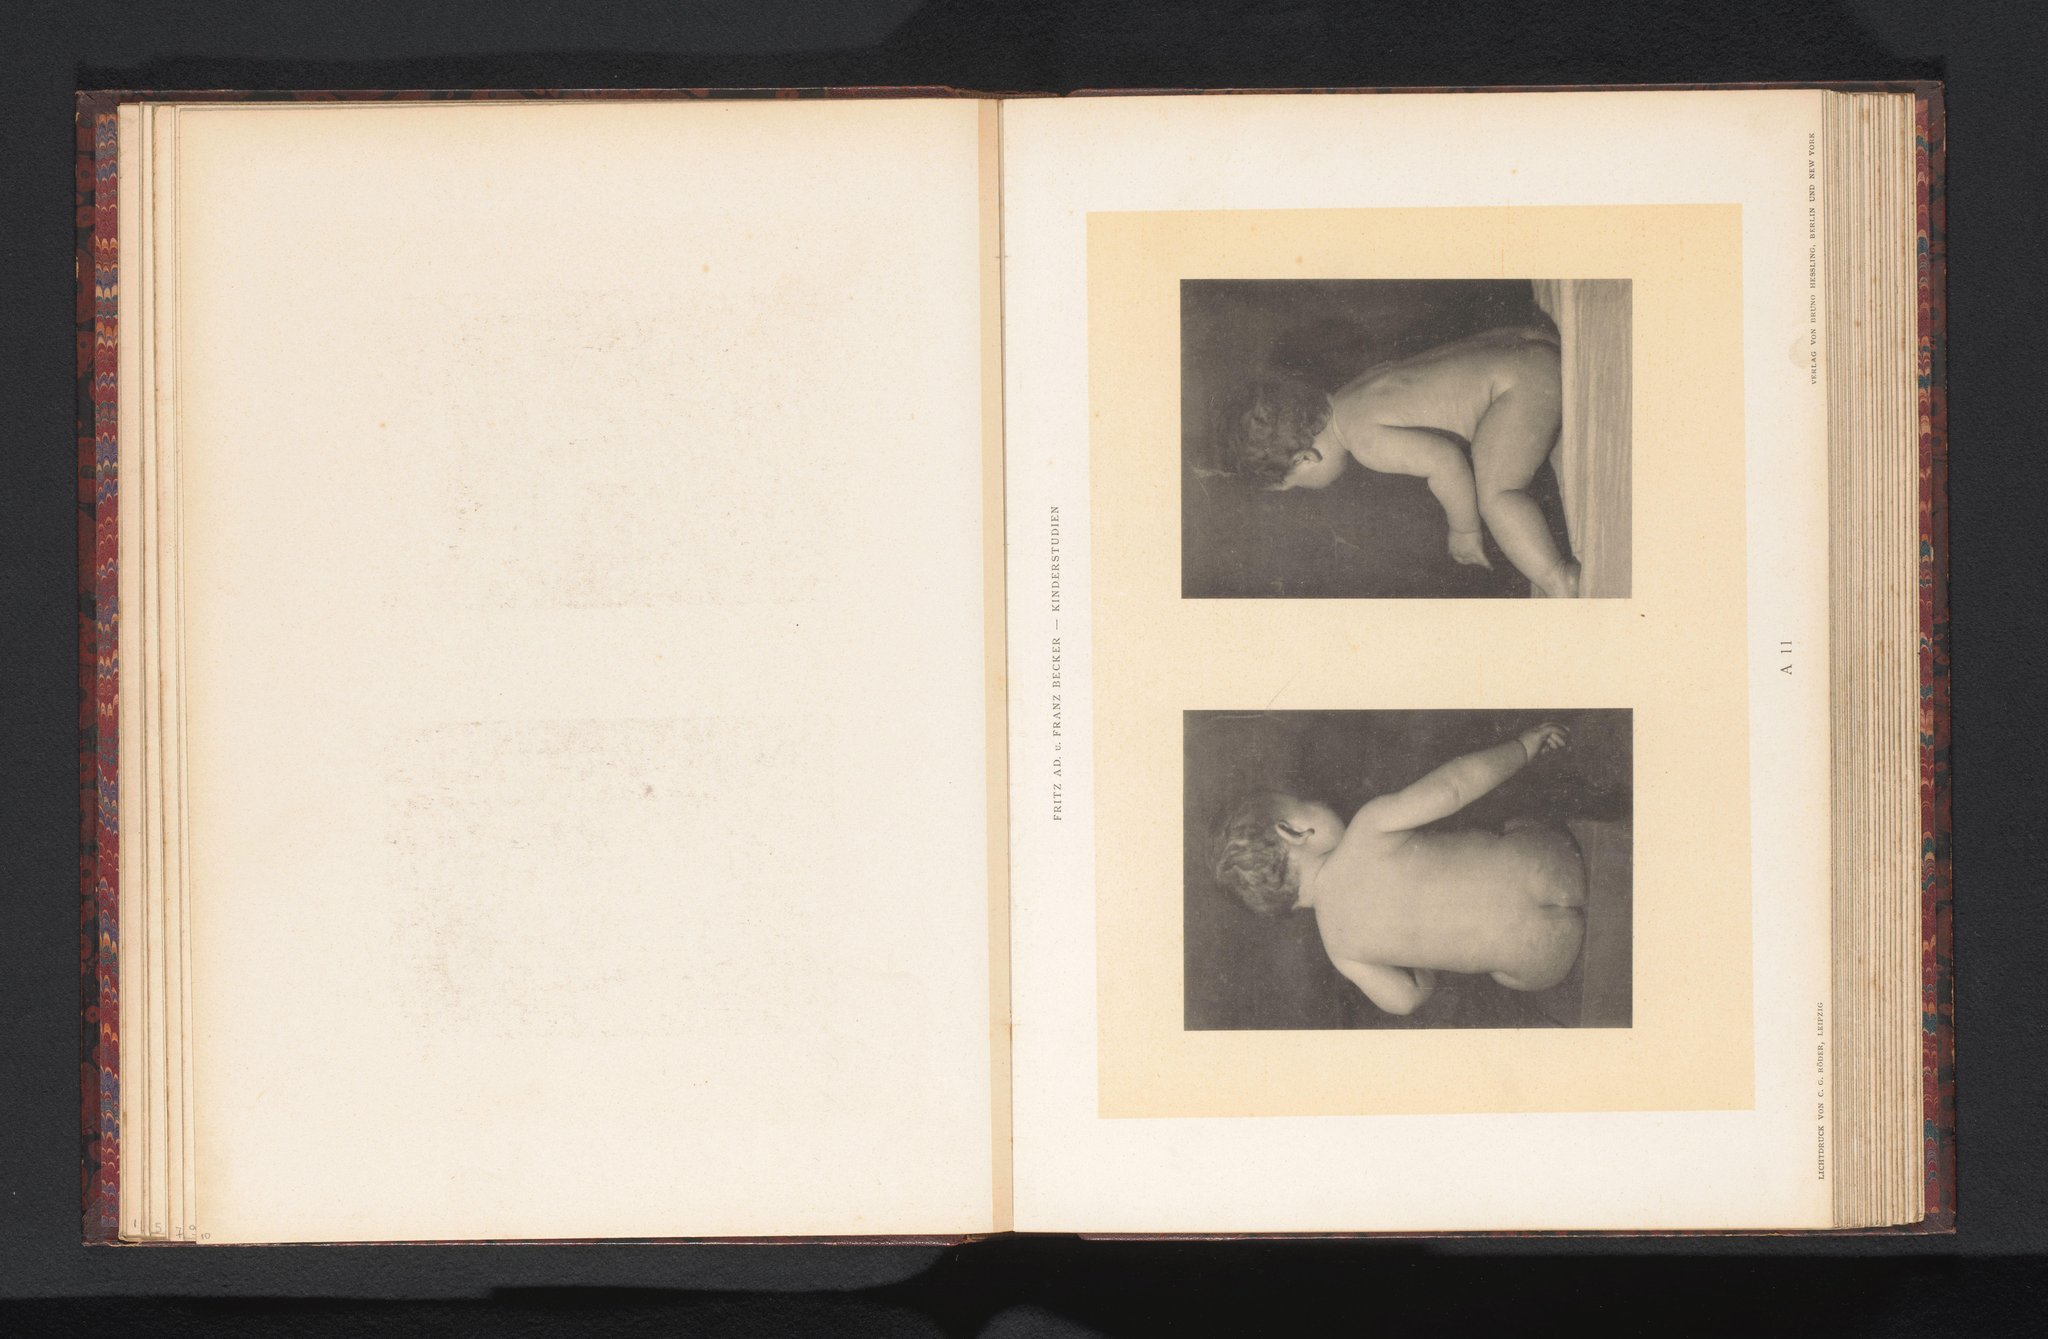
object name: page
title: Twee afbeeldingen van een zittende naakte jongen, op de rug gezien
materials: paper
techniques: photograph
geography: berlin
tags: sitting on the ground (+ back view), toddler (male)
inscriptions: number: ‘A 11’